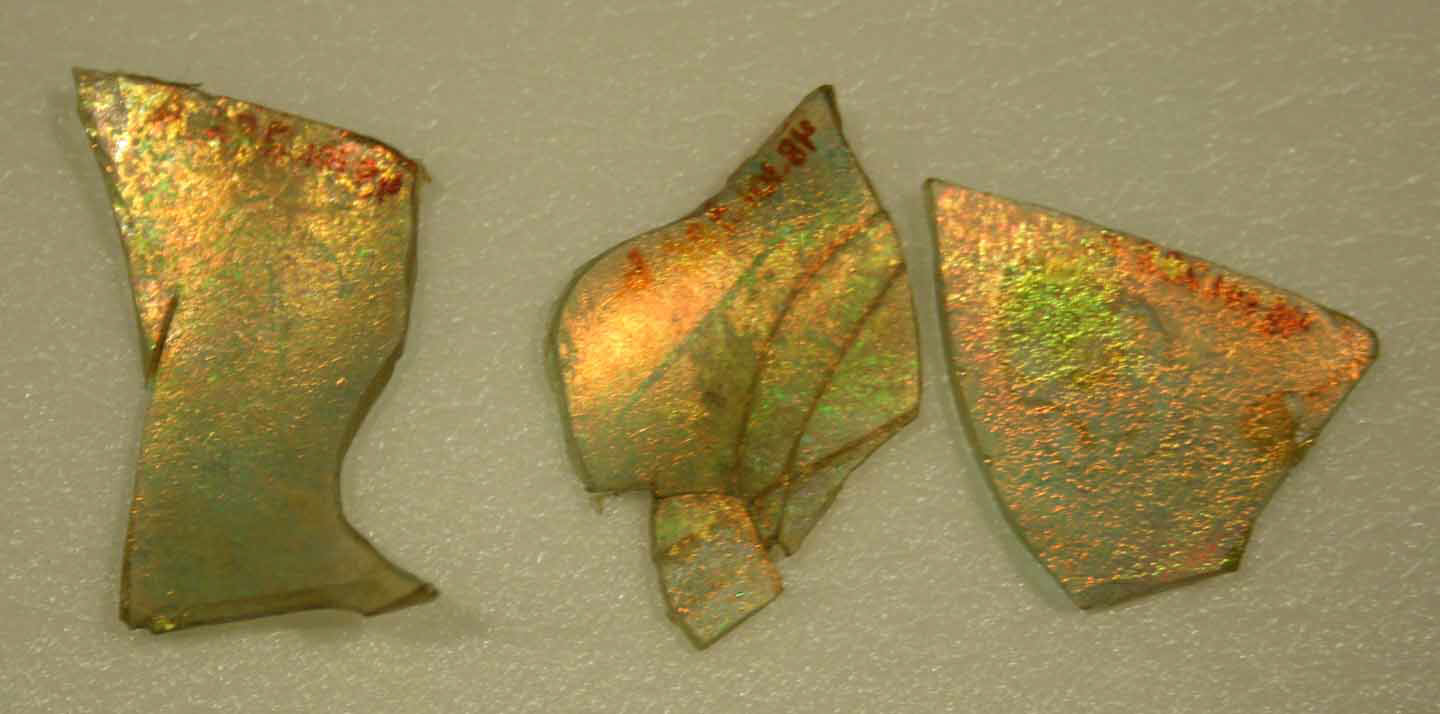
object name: fragment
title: Fragments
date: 801-1000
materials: glass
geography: iran